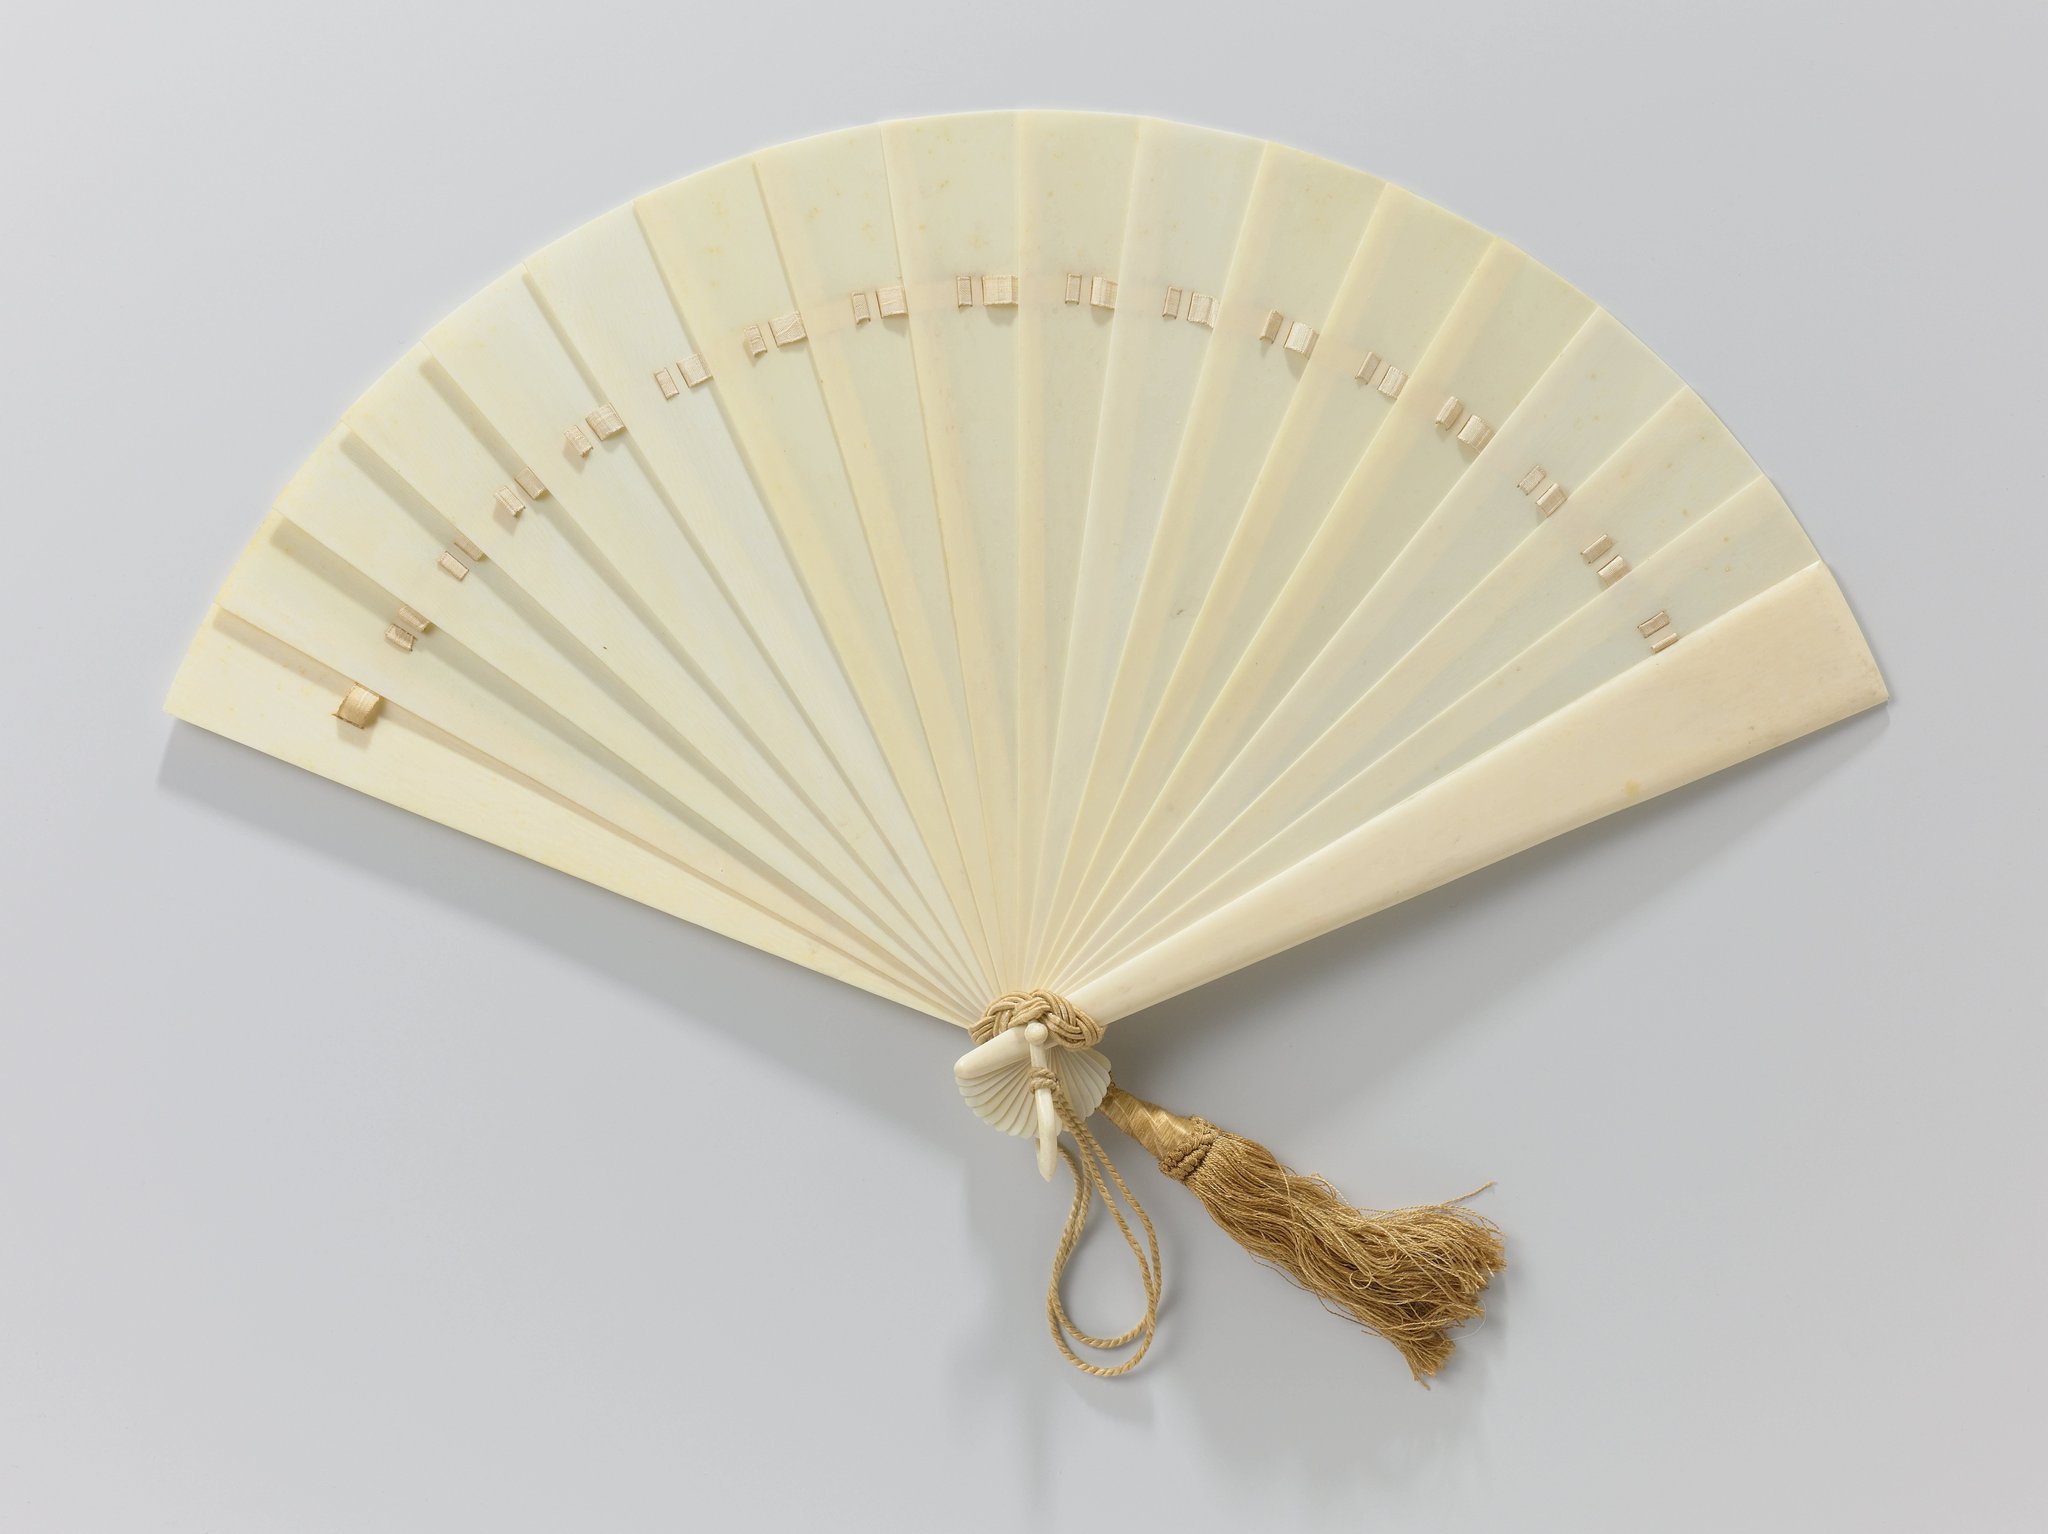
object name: brisé fan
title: Brisé-waaier geheel van ivoor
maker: Anonymous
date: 1890-1900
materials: ivory, silk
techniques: cutting, weave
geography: netherlands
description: Brisé-waaier geheel van ivoor. De 19 aaneengesloten benen zijn onversierd en door een zijden lint aan elkaar verbonden. Waaierring van ivoor, kwast en lus van zijde.